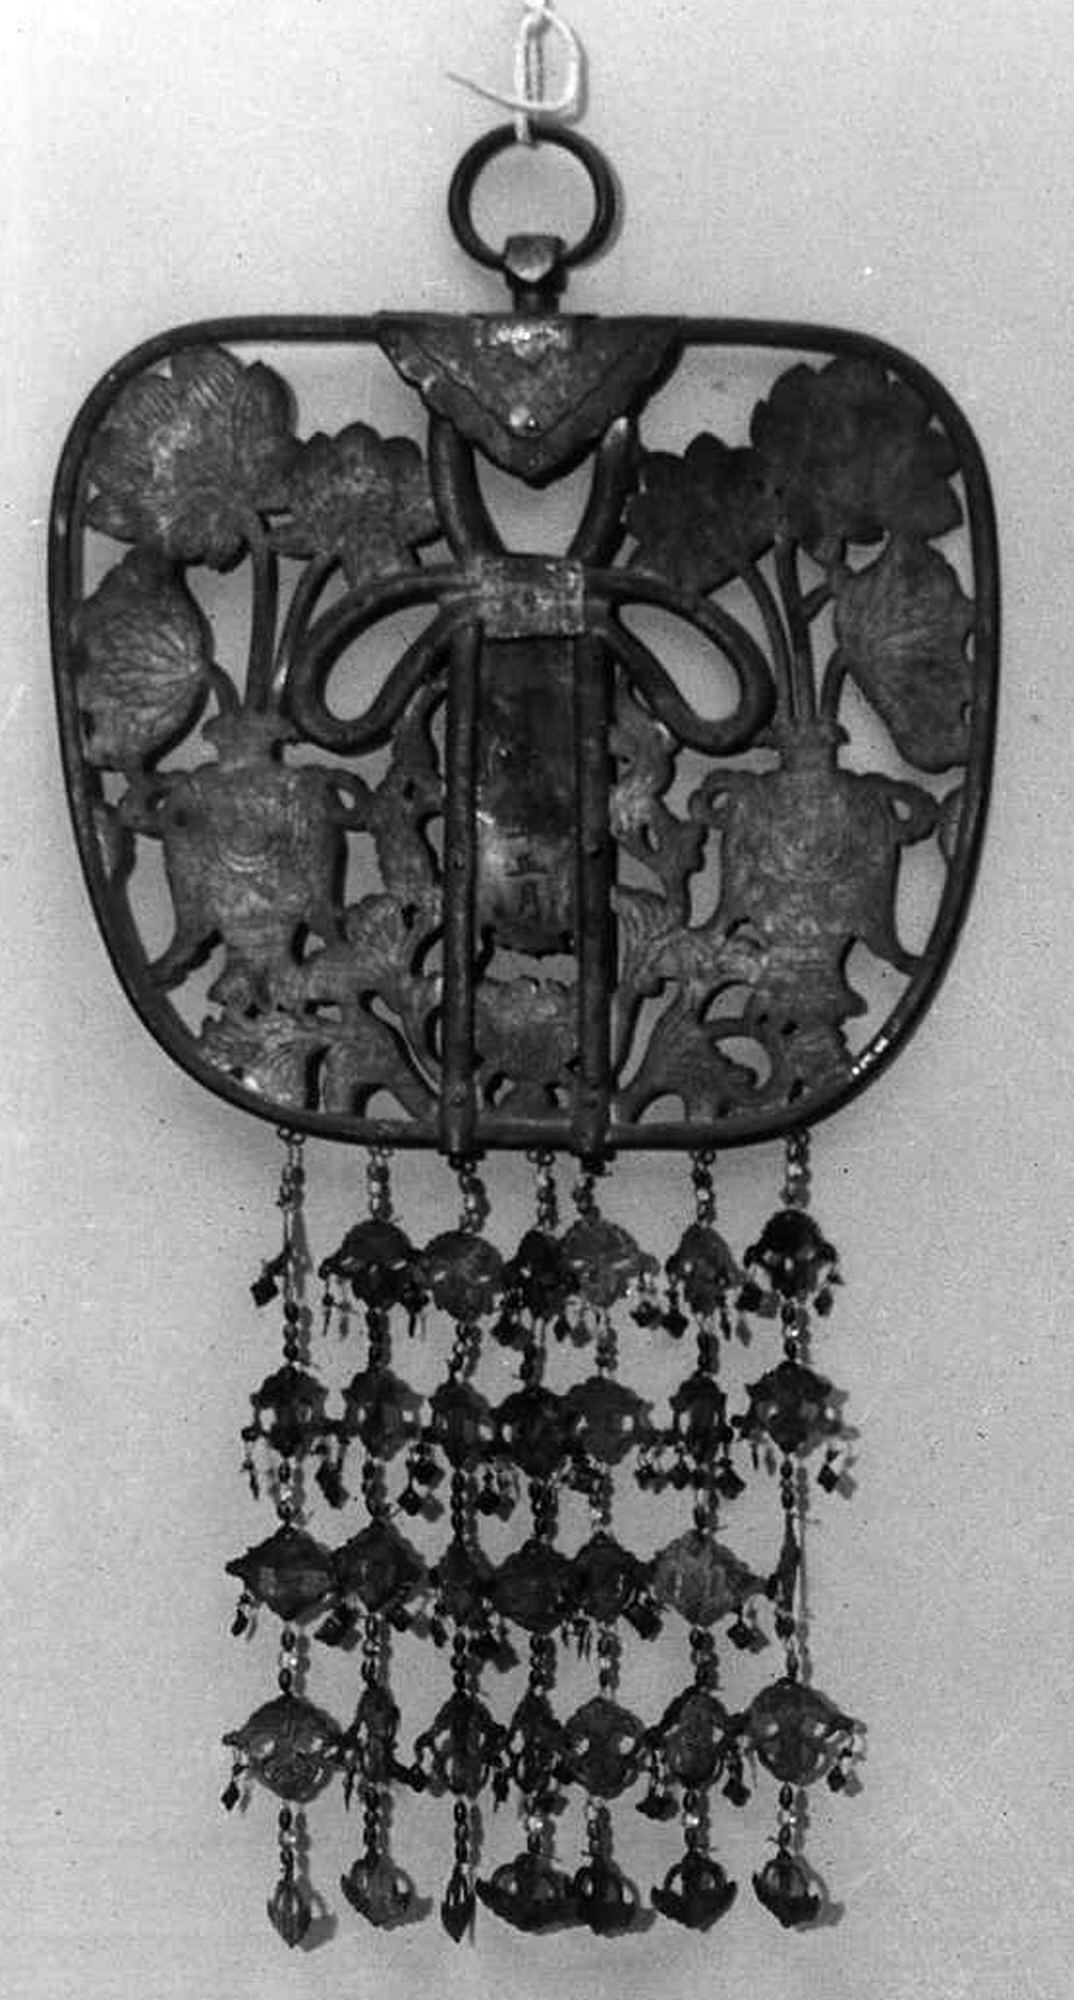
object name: temple decoration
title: Keman (“Flower Garland” Temple Decoration)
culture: japanese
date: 1725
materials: bronze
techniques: gilding